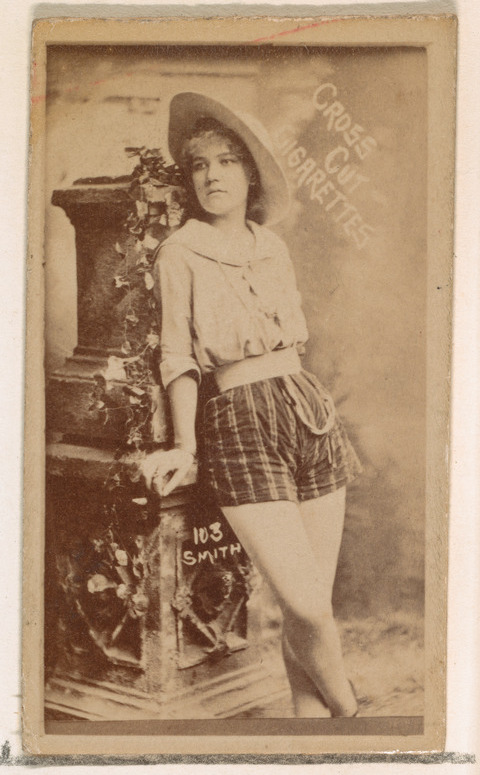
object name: print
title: Card Number 103, Smith, from the Actors and Actresses series (N145-1) issued by Duke Sons & Co. to promote Cross Cut Cigarettes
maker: w. duke, sons & co.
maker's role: publisher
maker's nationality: american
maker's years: 1870-1920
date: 1880-1889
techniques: albumen silver print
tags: portraits,women,actresses